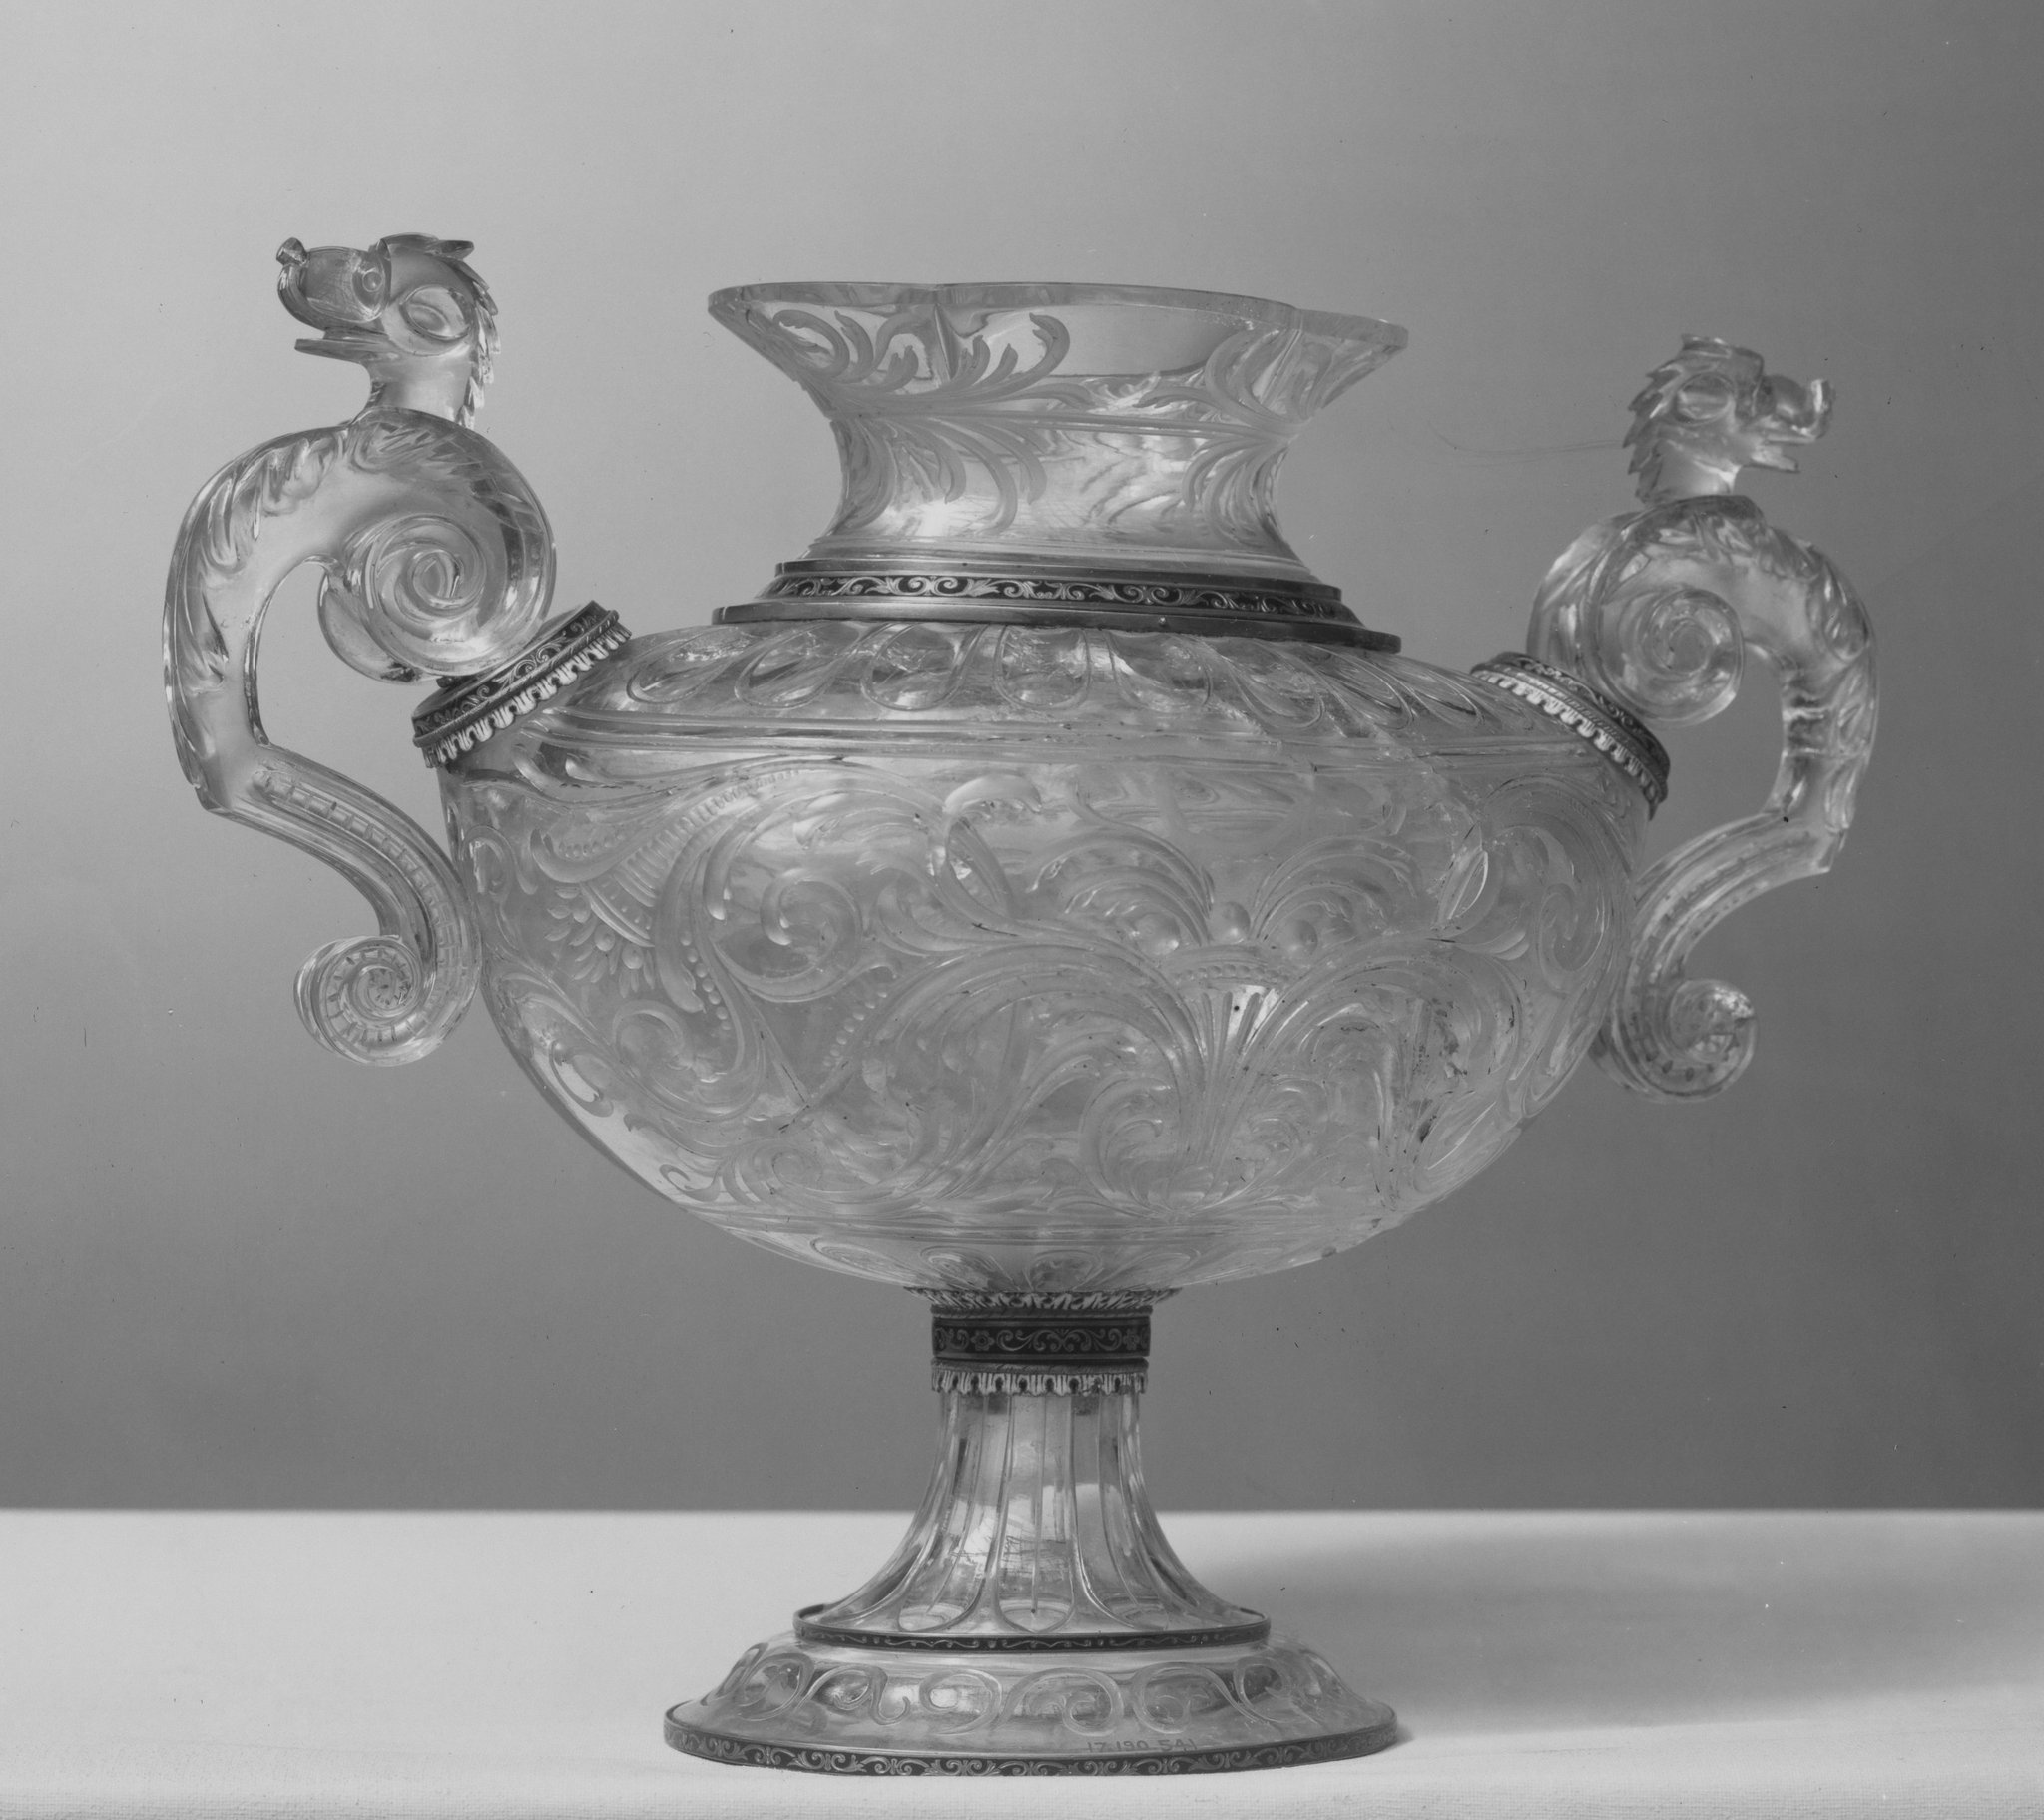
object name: vase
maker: morell of paris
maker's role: maker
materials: enamel, gold, quartz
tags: dragons